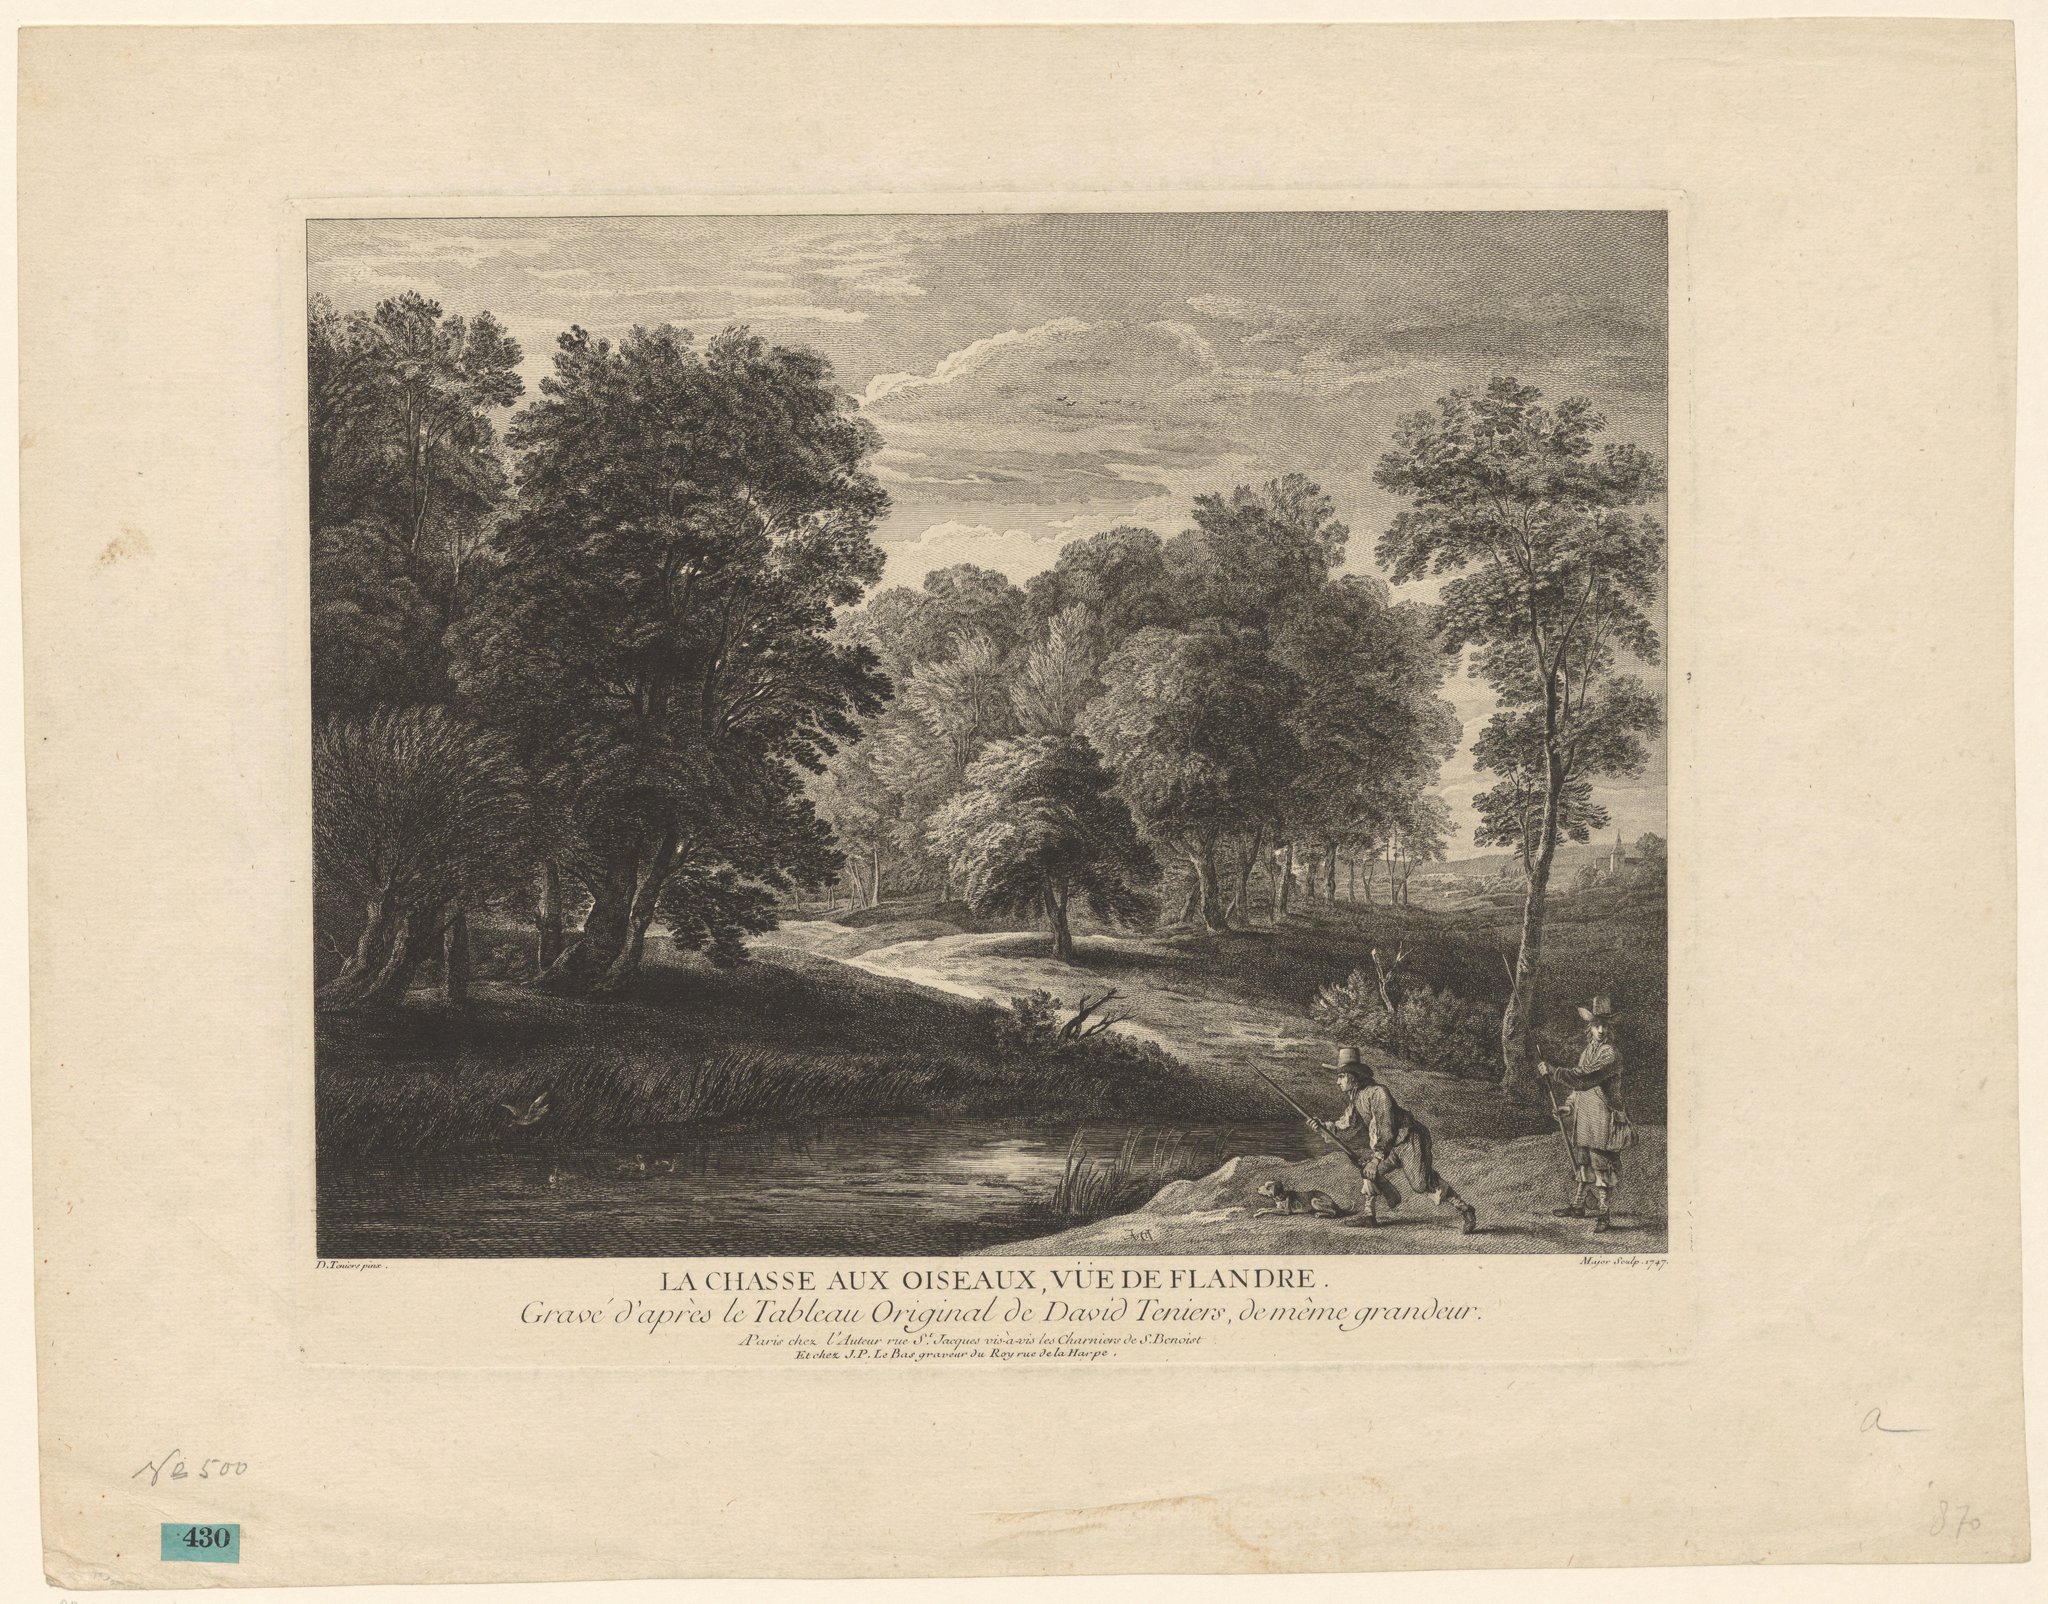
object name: print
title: La Chasse aux Oiseaux, Vüe de Flandre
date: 1747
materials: paper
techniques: etching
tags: bird hunting, forest, wood (+ landscape with figures, staffage)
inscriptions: collector's mark: Lugt 2028, collector's mark: Lugt 2228